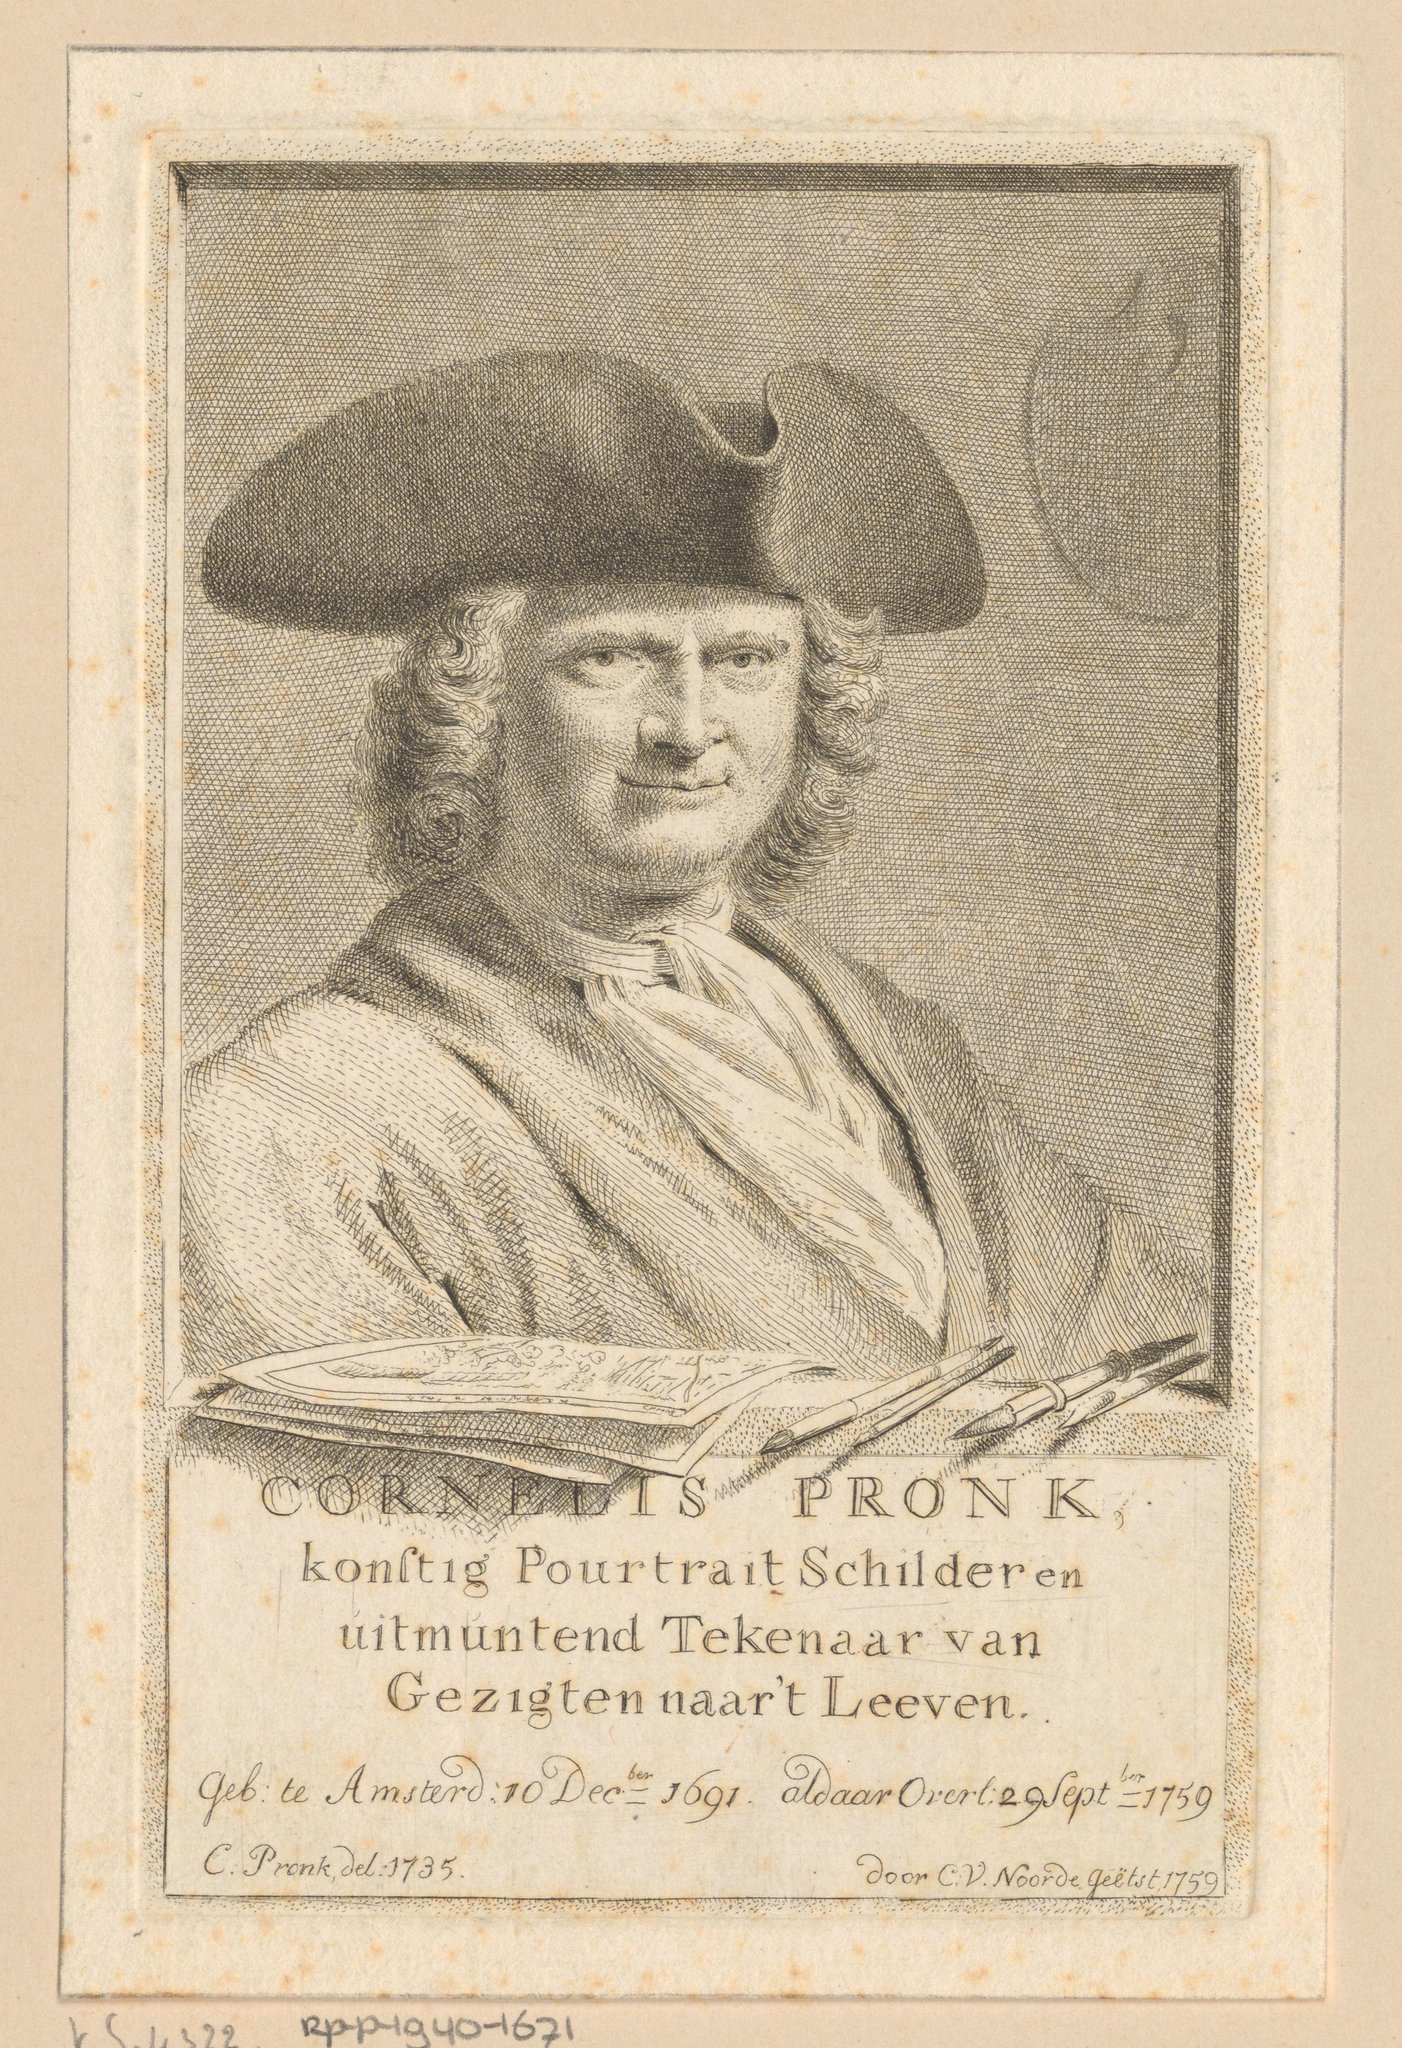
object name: print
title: Portret van Cornelis Pronk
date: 1759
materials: paper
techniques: etching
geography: haarlem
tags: amsterdam, painter, draughtsman, cornelis pronk, historical persons, tools, implements of painter, portrait, self-portrait of artist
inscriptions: collector's mark: Lugt 2760, collector's mark: Lugt 2166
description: Met vierregelig onderschrift in het Nederlands.